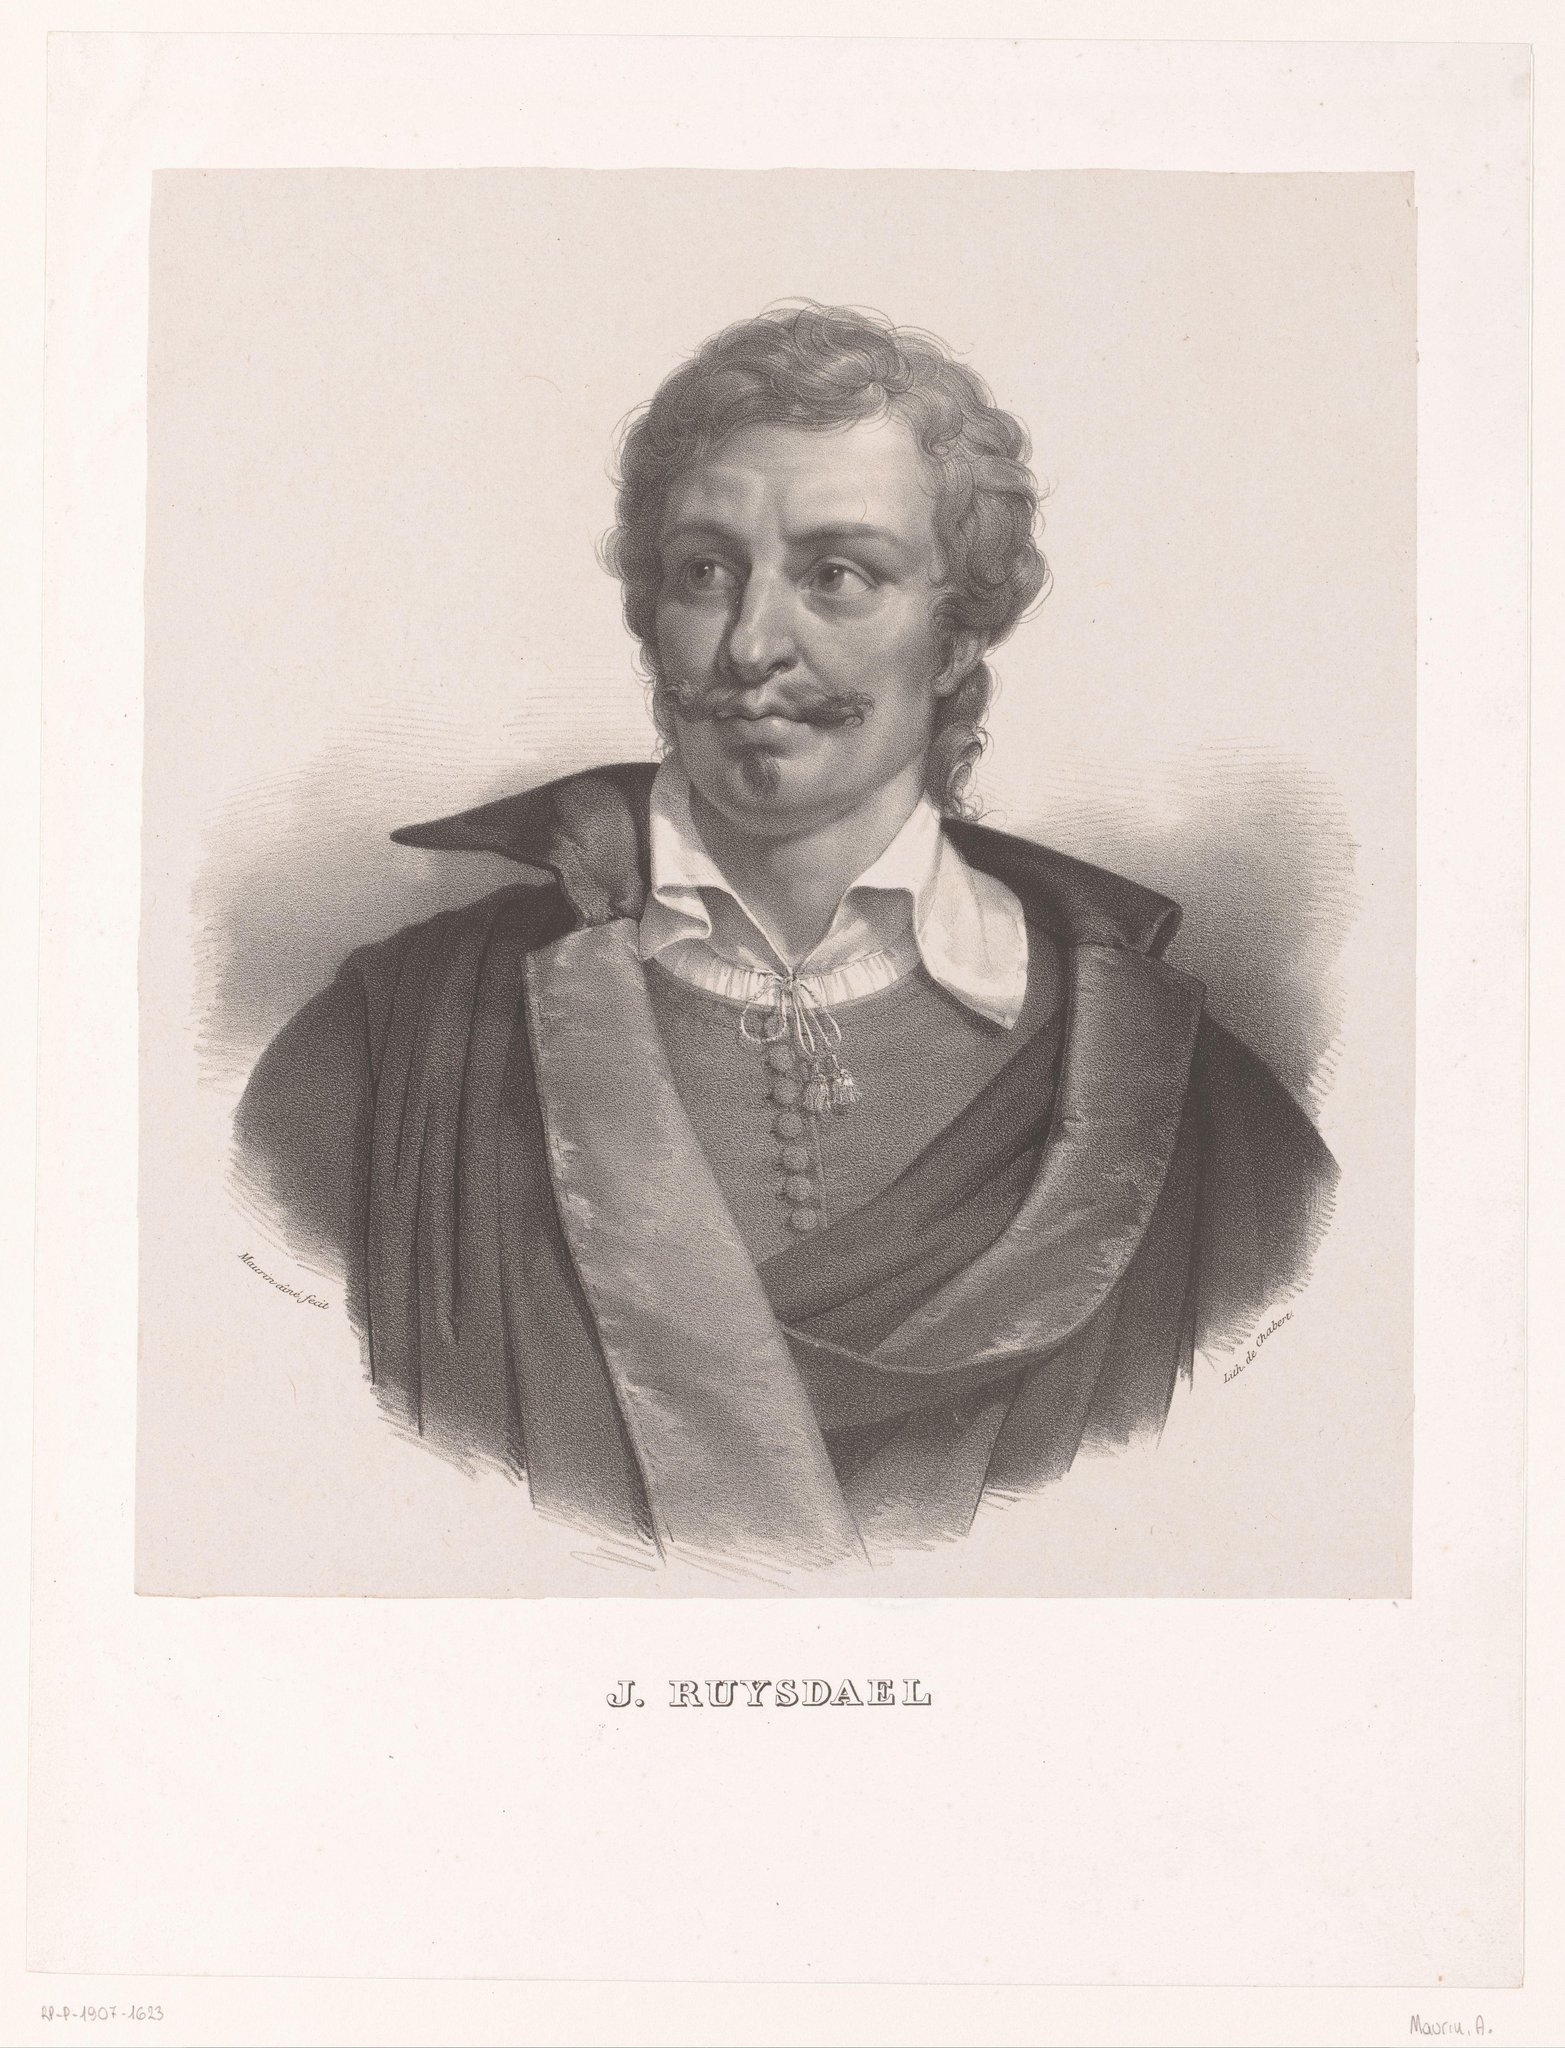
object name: print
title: Portret van Jacob van Ruysdael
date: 1827-1854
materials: paper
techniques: lithograph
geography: paris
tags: jacob van ruysdael, historical persons, portrait, self-portrait of painter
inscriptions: collector's mark: Lugt 2228, collector's mark: Lugt 2228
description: Prent ook gebruikt in: Chabert, Jean Claude. Galerie des peintres ou collection de portraits des peintres les plus célèbres de toutes les écoles. Accompagnée d'une notice sur chacun d'eux, et de copies de dessins originaux / Galerie des peintres ou collection de portraits des peintres les plus célèbres de toutes les écoles. Accompagnée de leur notice historique, de leurs dessins et d'un discours sur les arts. Parijs: Jean Claude Chabert, s.a. [1822-1834]. De samenstelling van tegenwoordig bekende en al dan niet gebonden exemplaren van deze uitgave verschillen. Dit omdat de prenten en bijhorende stukken tekst op inschrijving en waarschijnlijk ook los verkrijgbaar waren.